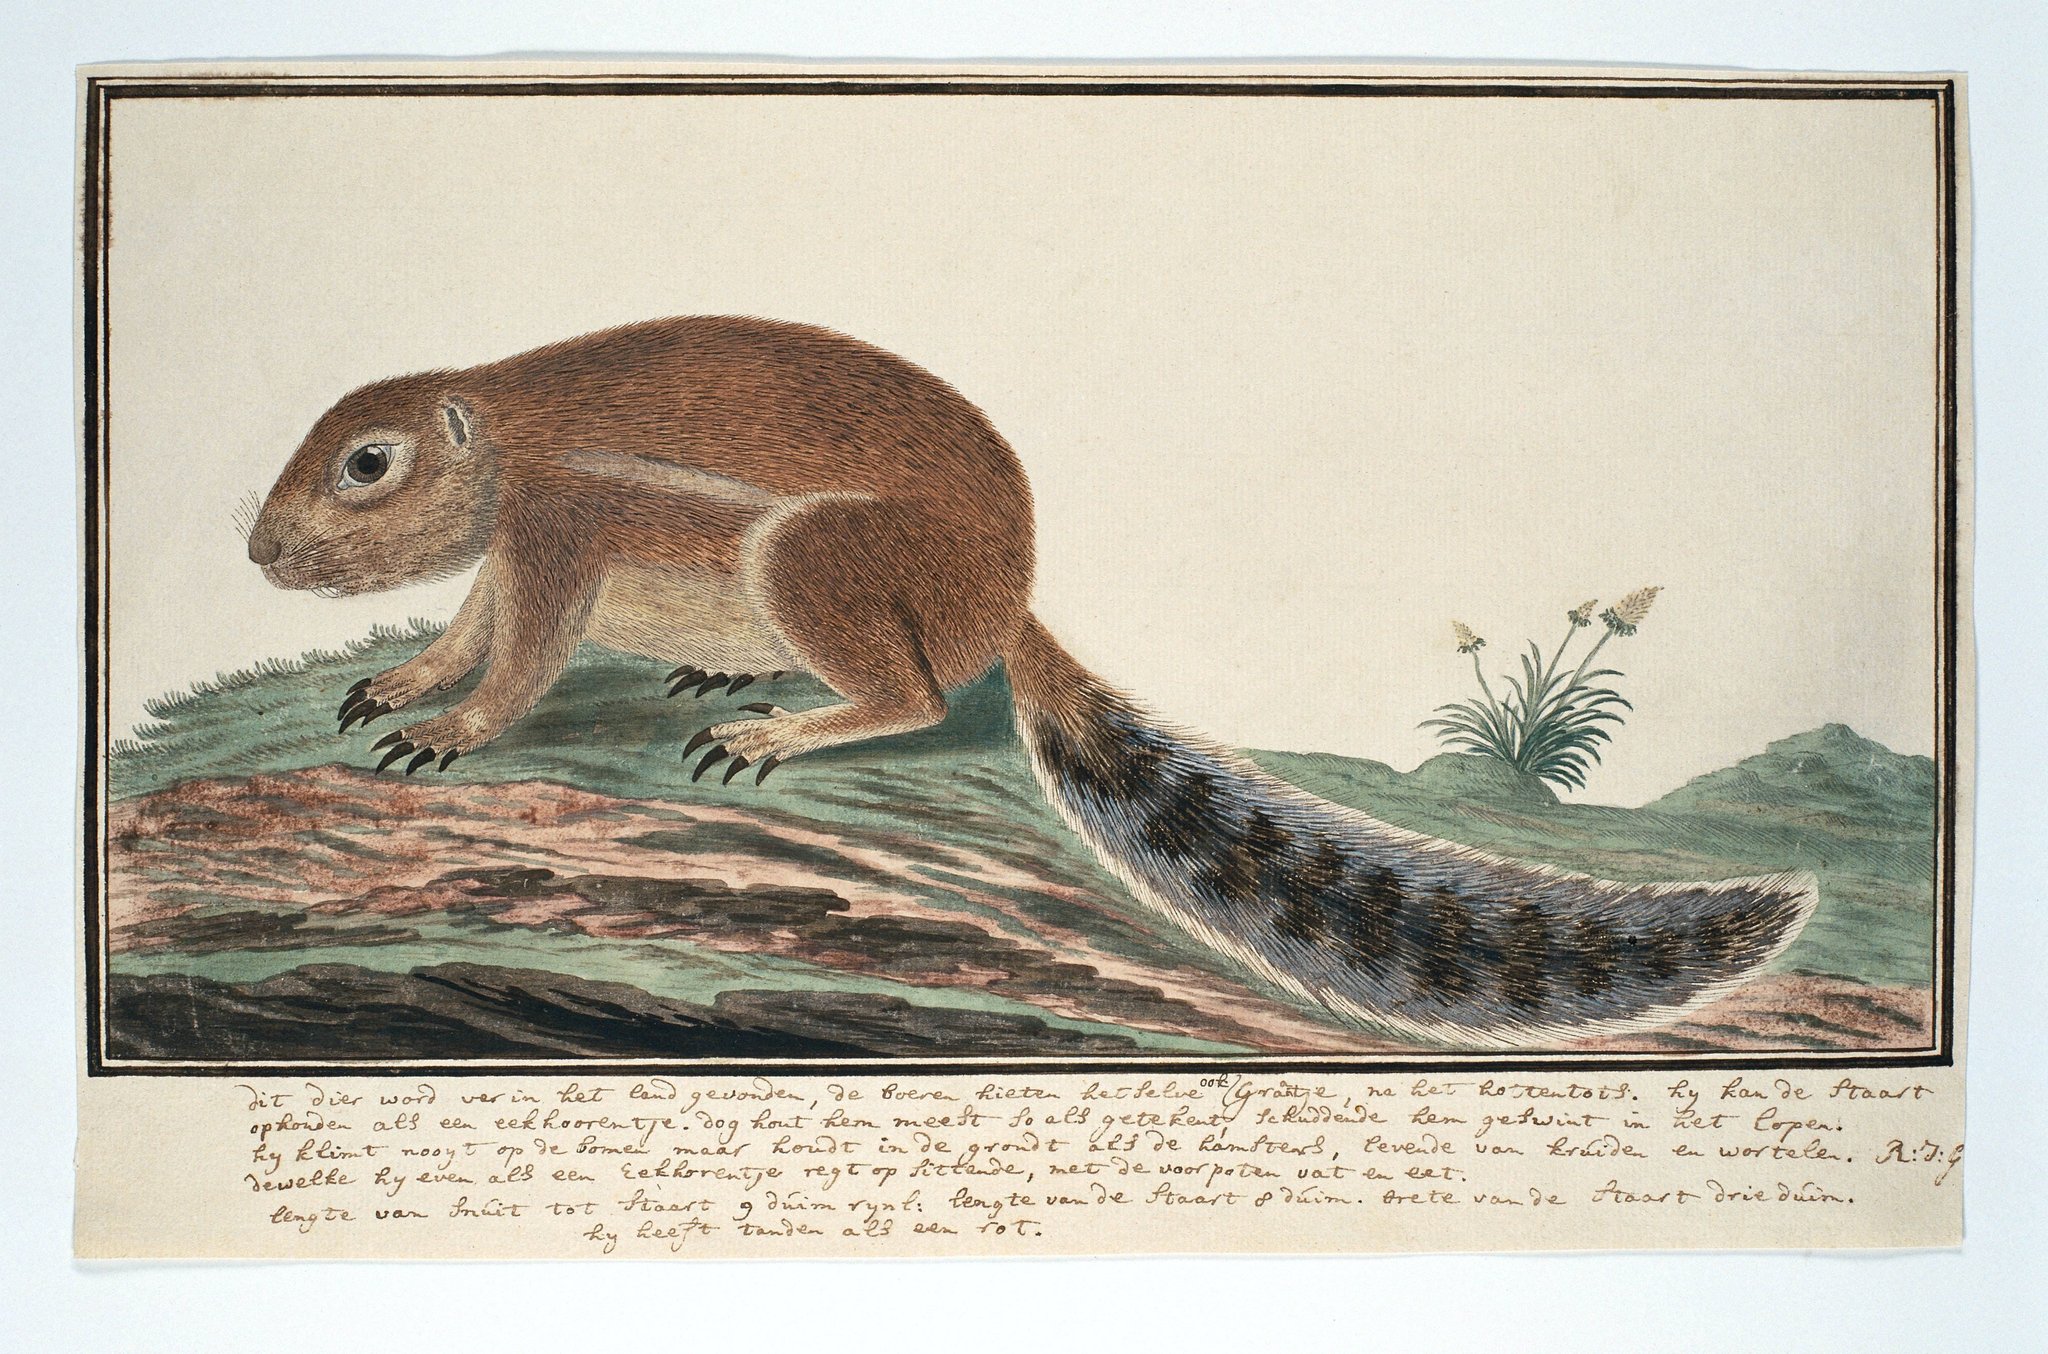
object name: album leaf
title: Xerus inauris (Cape ground squirrel)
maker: robert jacob gordon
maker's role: draughtsman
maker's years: 1743-1795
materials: chalk, paint, ink, paper, pencil, watercolor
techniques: brush, pen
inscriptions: initials: ‘[...] R: J: G (afgesneden)’, annotation: ‘dit dier word ver in het land gevonden, de boeren hieten hetselve ook [boven ingevoegd] Graatje, na het hottentots. [...]’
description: Eekhoorn (Xerus inauris), ook 'graatje' genoemd, deze naam wordt ook gebruikt voor het stokstaartje (Suricata); is geen boomklimmer.